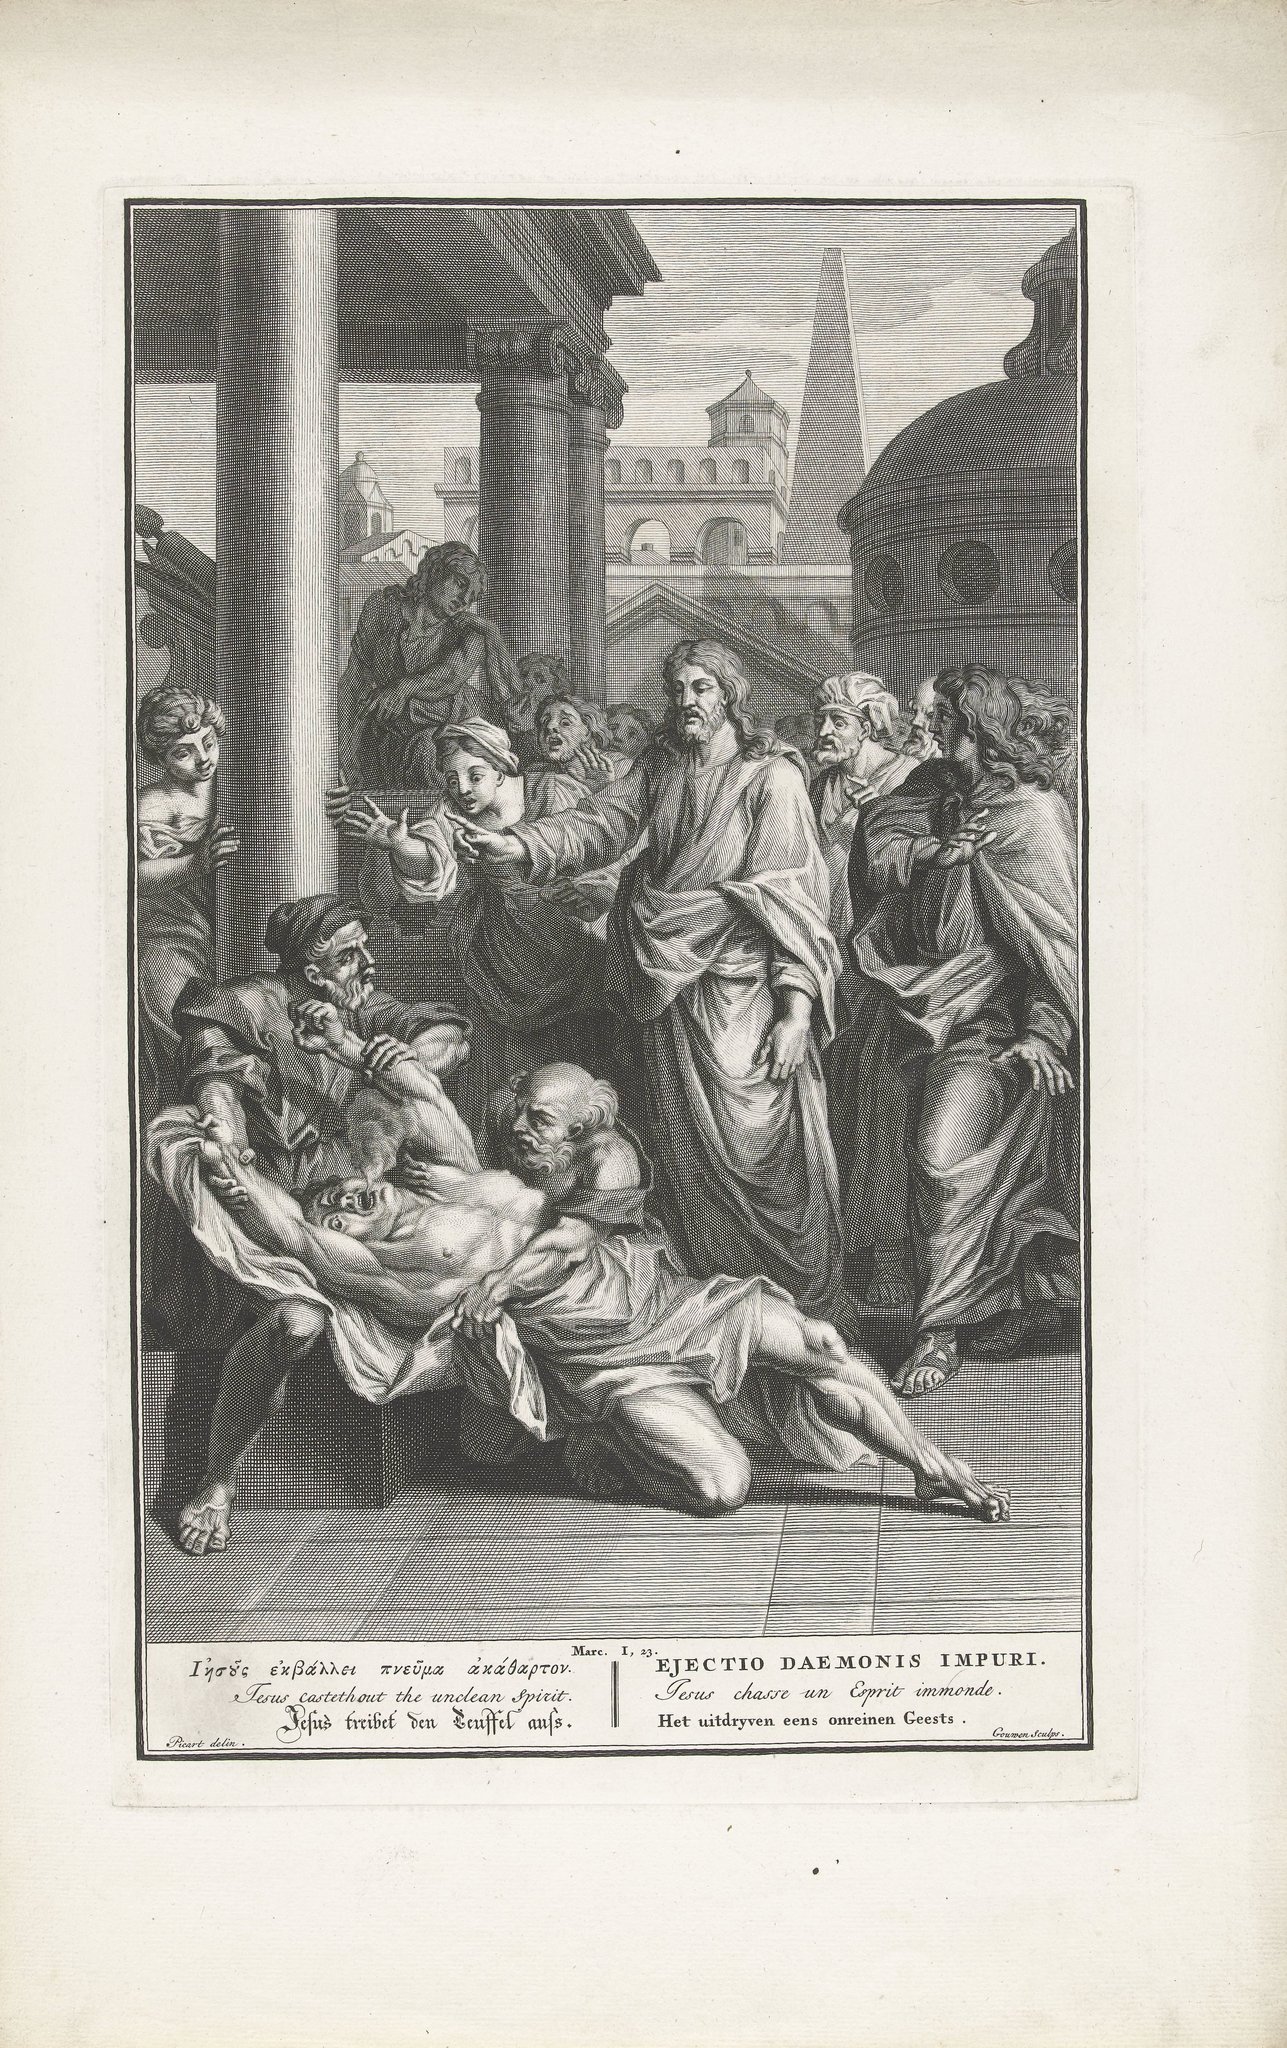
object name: print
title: Christus geneest een bezeten man in de synagoge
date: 1728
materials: paper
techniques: engraving, etching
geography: amsterdam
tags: healing of a possessed man in a synagogue (mark 1:23-28; luke 4:33-37)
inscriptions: inscription: ‘utrechts Fundatie huijs’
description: Christus beveelt een onreine geest te vertrekken uit een bezeten man. De onreine geest doet de man stuiptrekken en verlaat hem (Mar. 1:23). De prent heeft een Grieks, Latijns, Frans, Engels, Duits en Nederlands onderschrift.